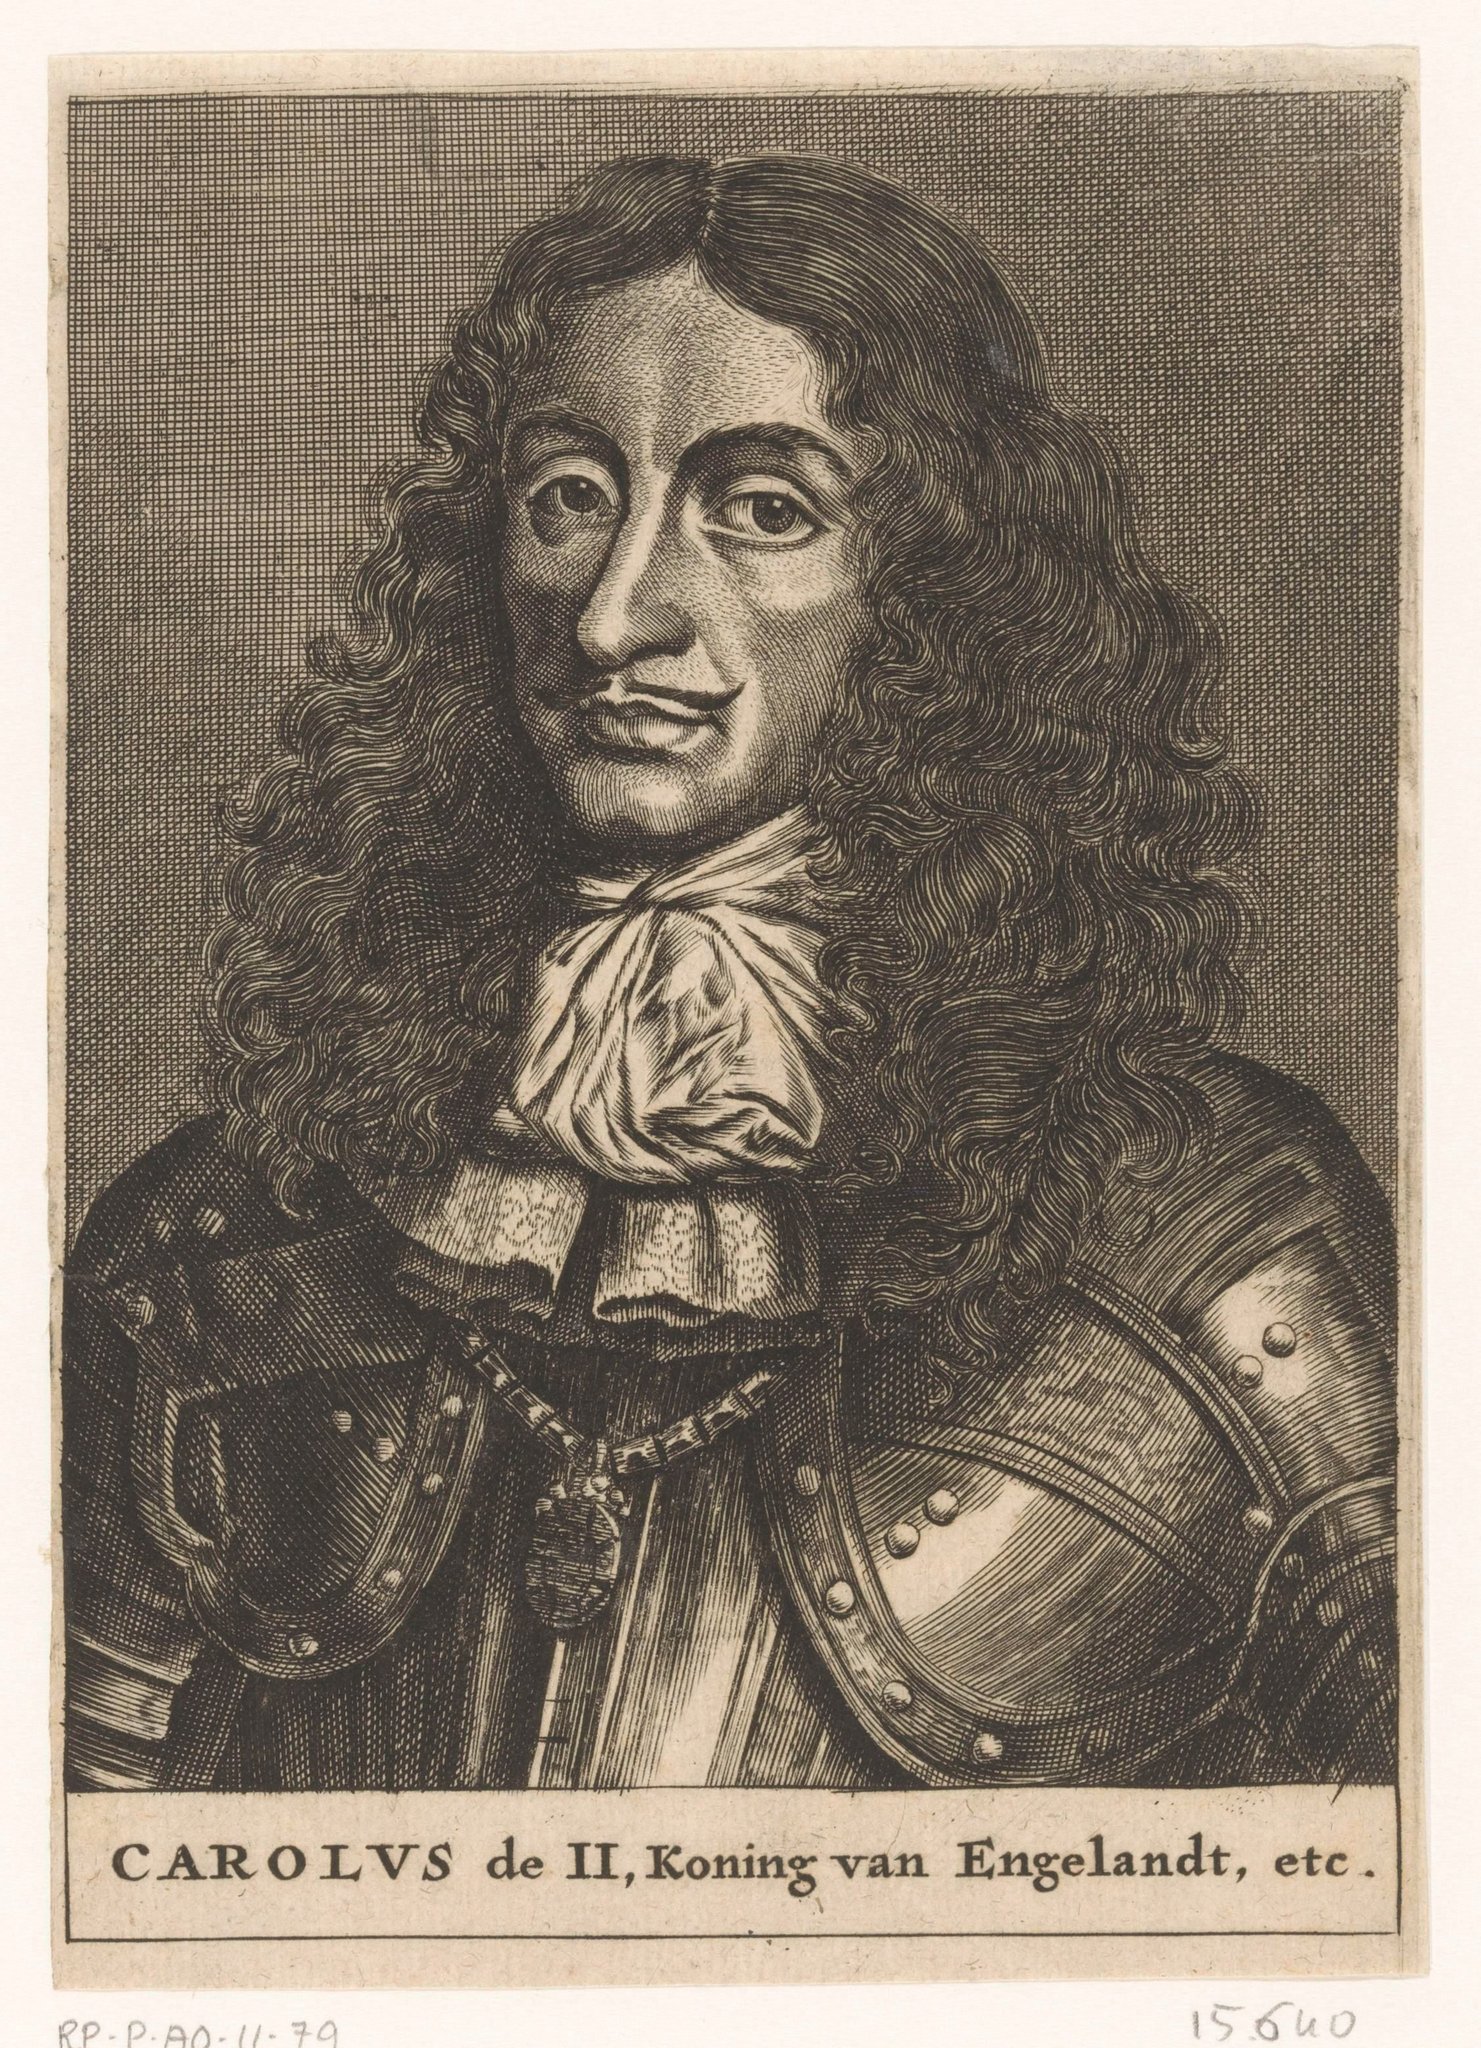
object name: book illustration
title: Portret van koning Karel II van Engeland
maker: Anonymous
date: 1674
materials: paper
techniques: engraving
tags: karel ii (koning van engeland), historical persons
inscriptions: collector's mark: Lugt 2228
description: Prent ook gebruikt in: Domselaer, Tobias van. Het ontroerde Nederlandt, door de wapenen des konings van Vrankryk (…). 2 delen. Amsterdam: Marcus Willemsz. Doornick, 1674-1676, dl. 1 (1674), tussen p. 86 en 87.